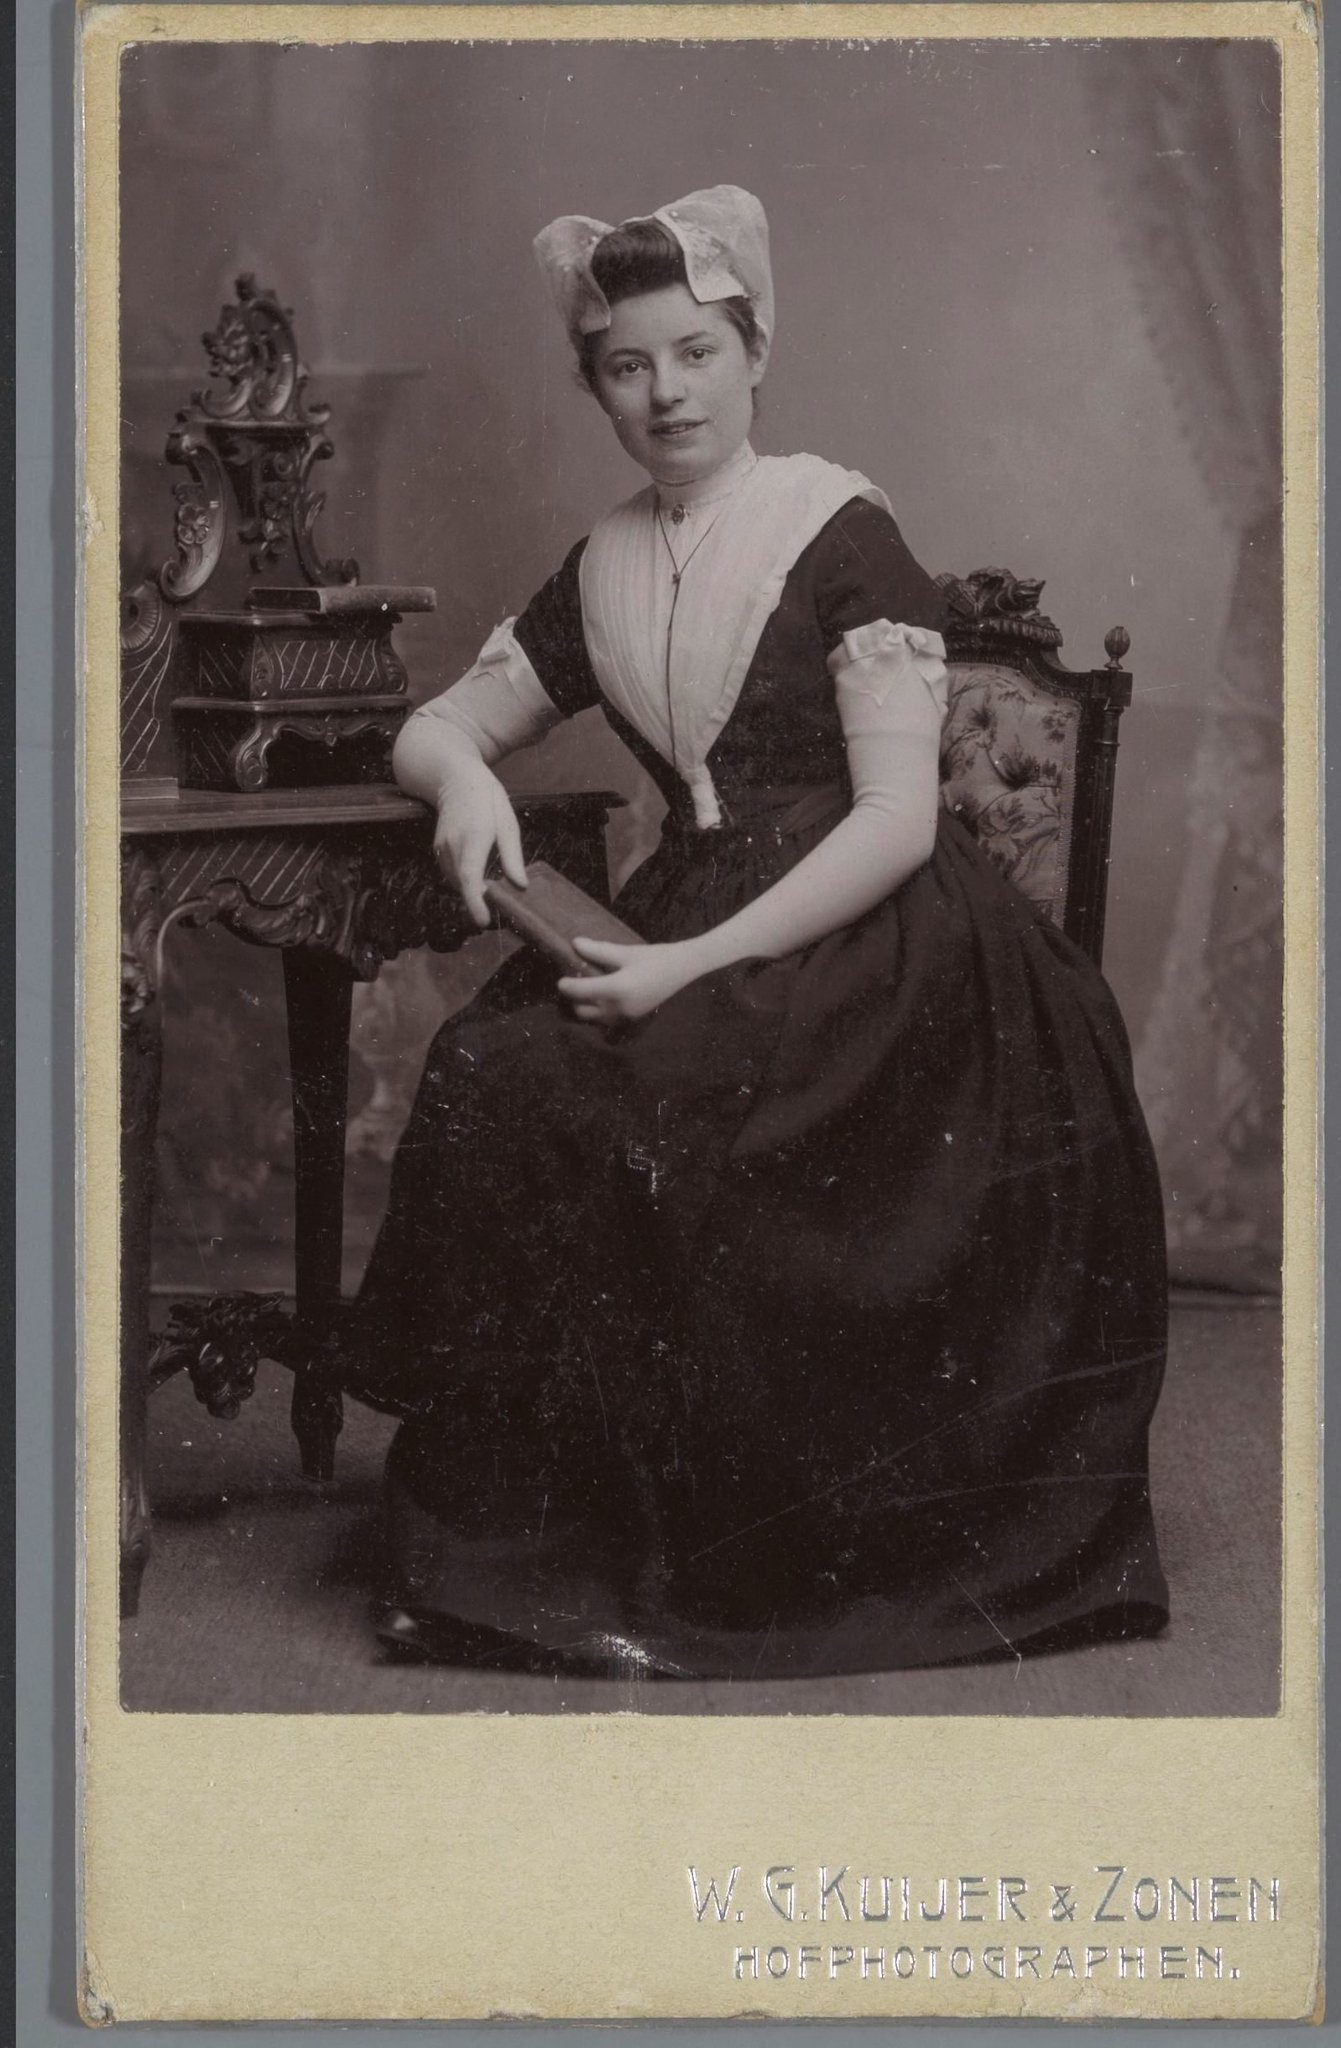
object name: carte de visite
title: Portret van een onbekende jonge vrouw in in de dracht van het Burgerweeshuis in Amsterdam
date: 1885-1906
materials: paper, cardboard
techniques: gelatin silver print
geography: amsterdam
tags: adolescent, young woman, maiden, anonymous historical person portrayed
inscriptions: inscription: ‘W.G. Kuijer & Zonen/ Hofphotographen.’, inscription: ‘W.G. Kuijer en Zonen/ Hofphotographen/ Amsterdam/ Westermarkt 19./ Speciale inrichting/ voor/ vergrootingen in alle formaten.’